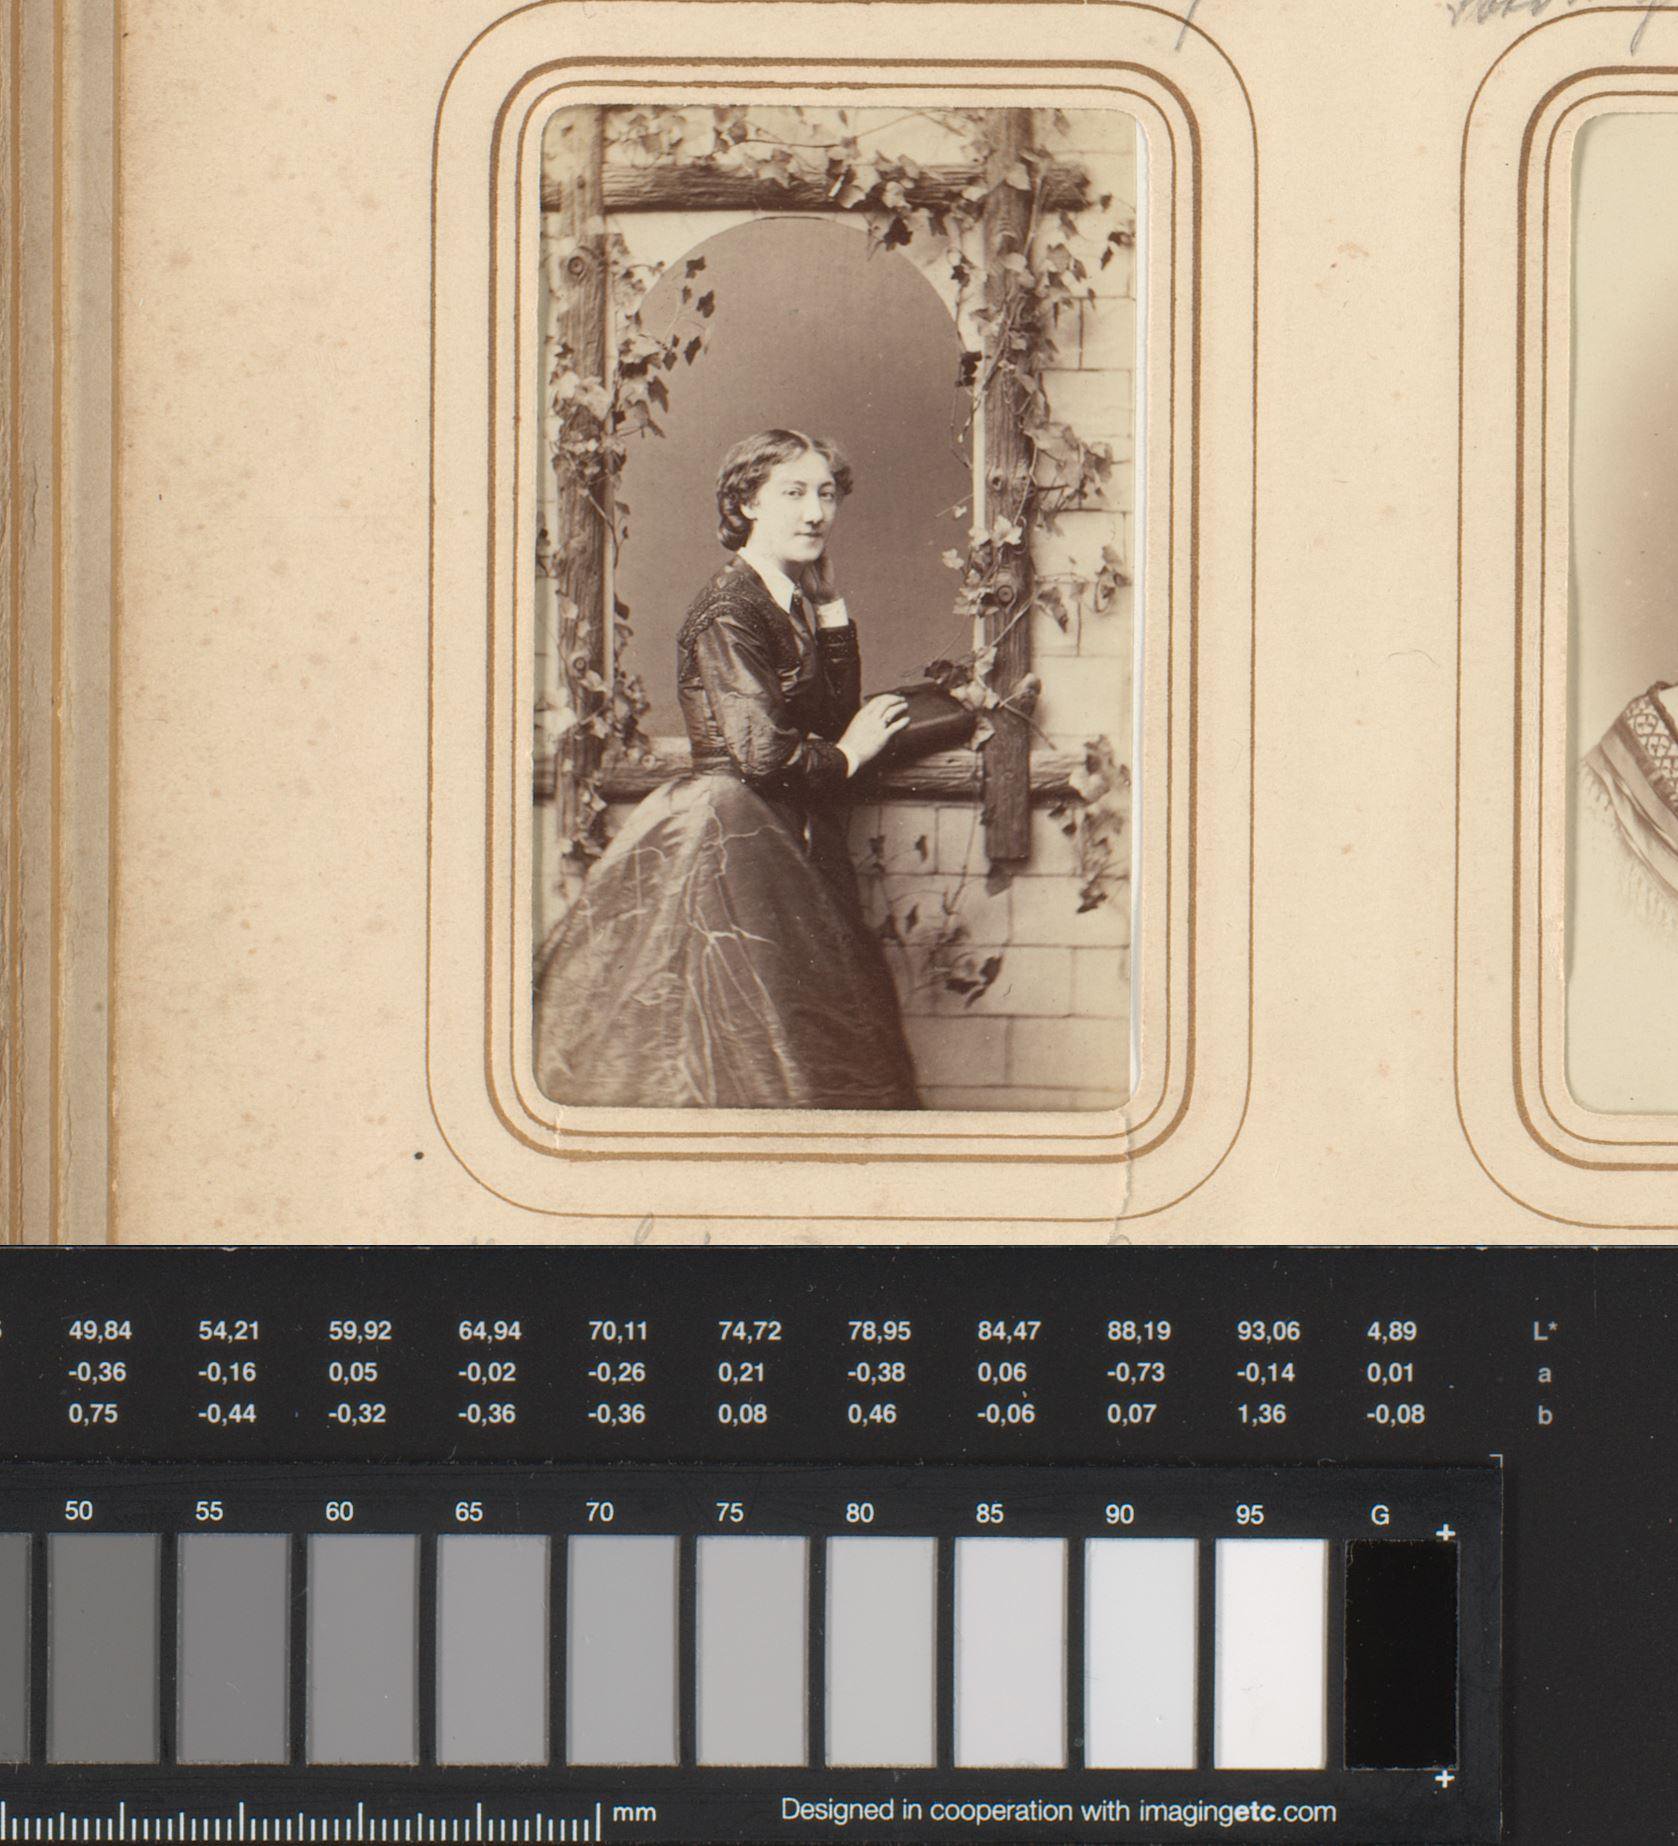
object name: carte de visite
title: Portret van een vrouw, mogelijk Marie Niemen Lesbach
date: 1870-1890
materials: cardboard, photographic support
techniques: albumen print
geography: wiesbaden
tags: adult woman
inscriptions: inscription: ‘[...] Leben/ zur erinnerung an/ Marie Niemen Lesbach’, name: ‘Mondel & Jacob Wiesbaden’, date: ‘[...] 10. Febr. 69’, inscription: ‘Mondel & Jacob / Wiesbaden / Trinkhalle. [...]’